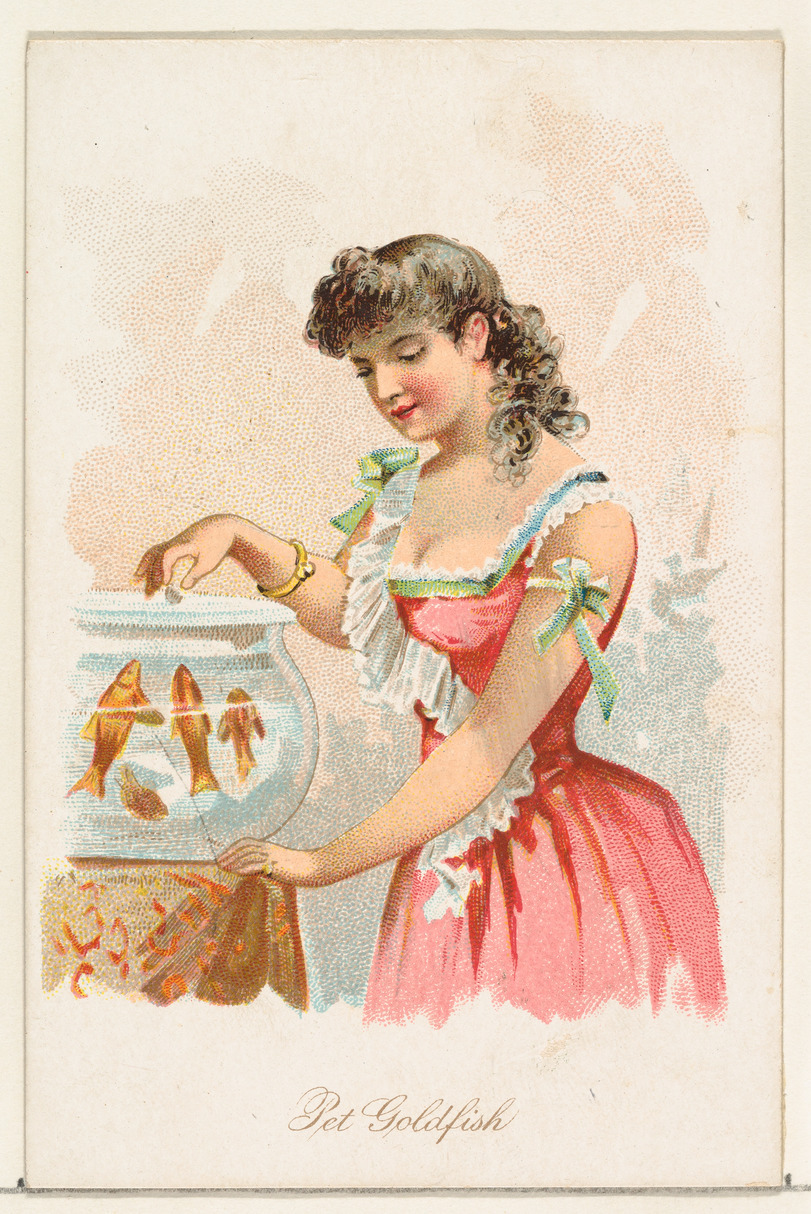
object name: print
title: Pet Goldfish, from the Household Pets series (N194) issued by Wm. S. Kimball & Co.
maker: william s. kimball & company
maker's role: publisher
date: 1891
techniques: color lithograph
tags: women,fish